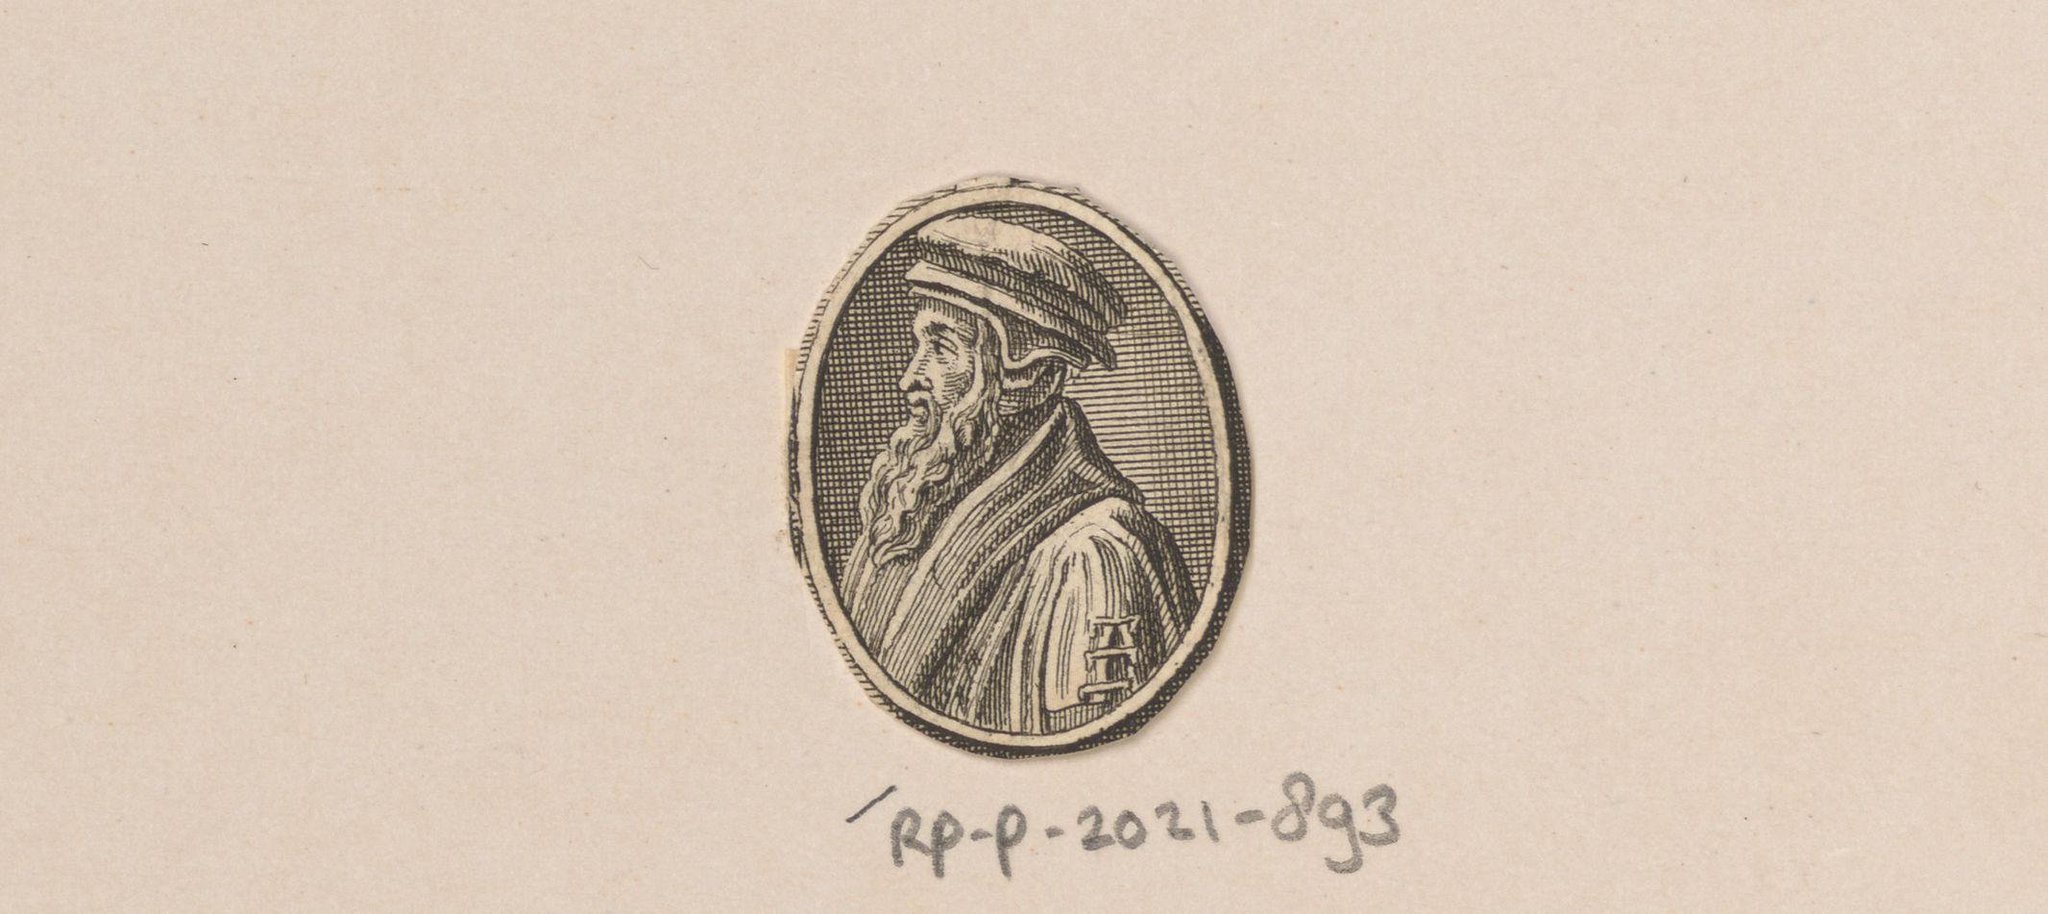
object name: print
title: Portret van Johannes a Lasco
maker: Anonymous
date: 1600-1750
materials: paper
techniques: etching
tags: theologian, historical persons